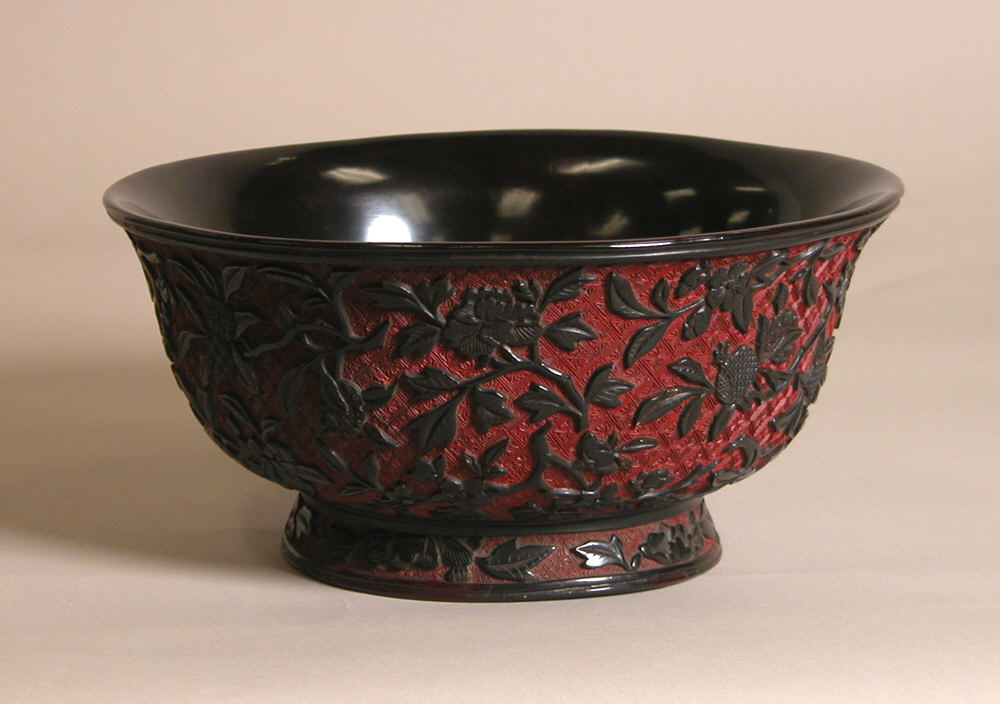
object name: bowl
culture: chinese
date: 1701-1800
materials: lacquer